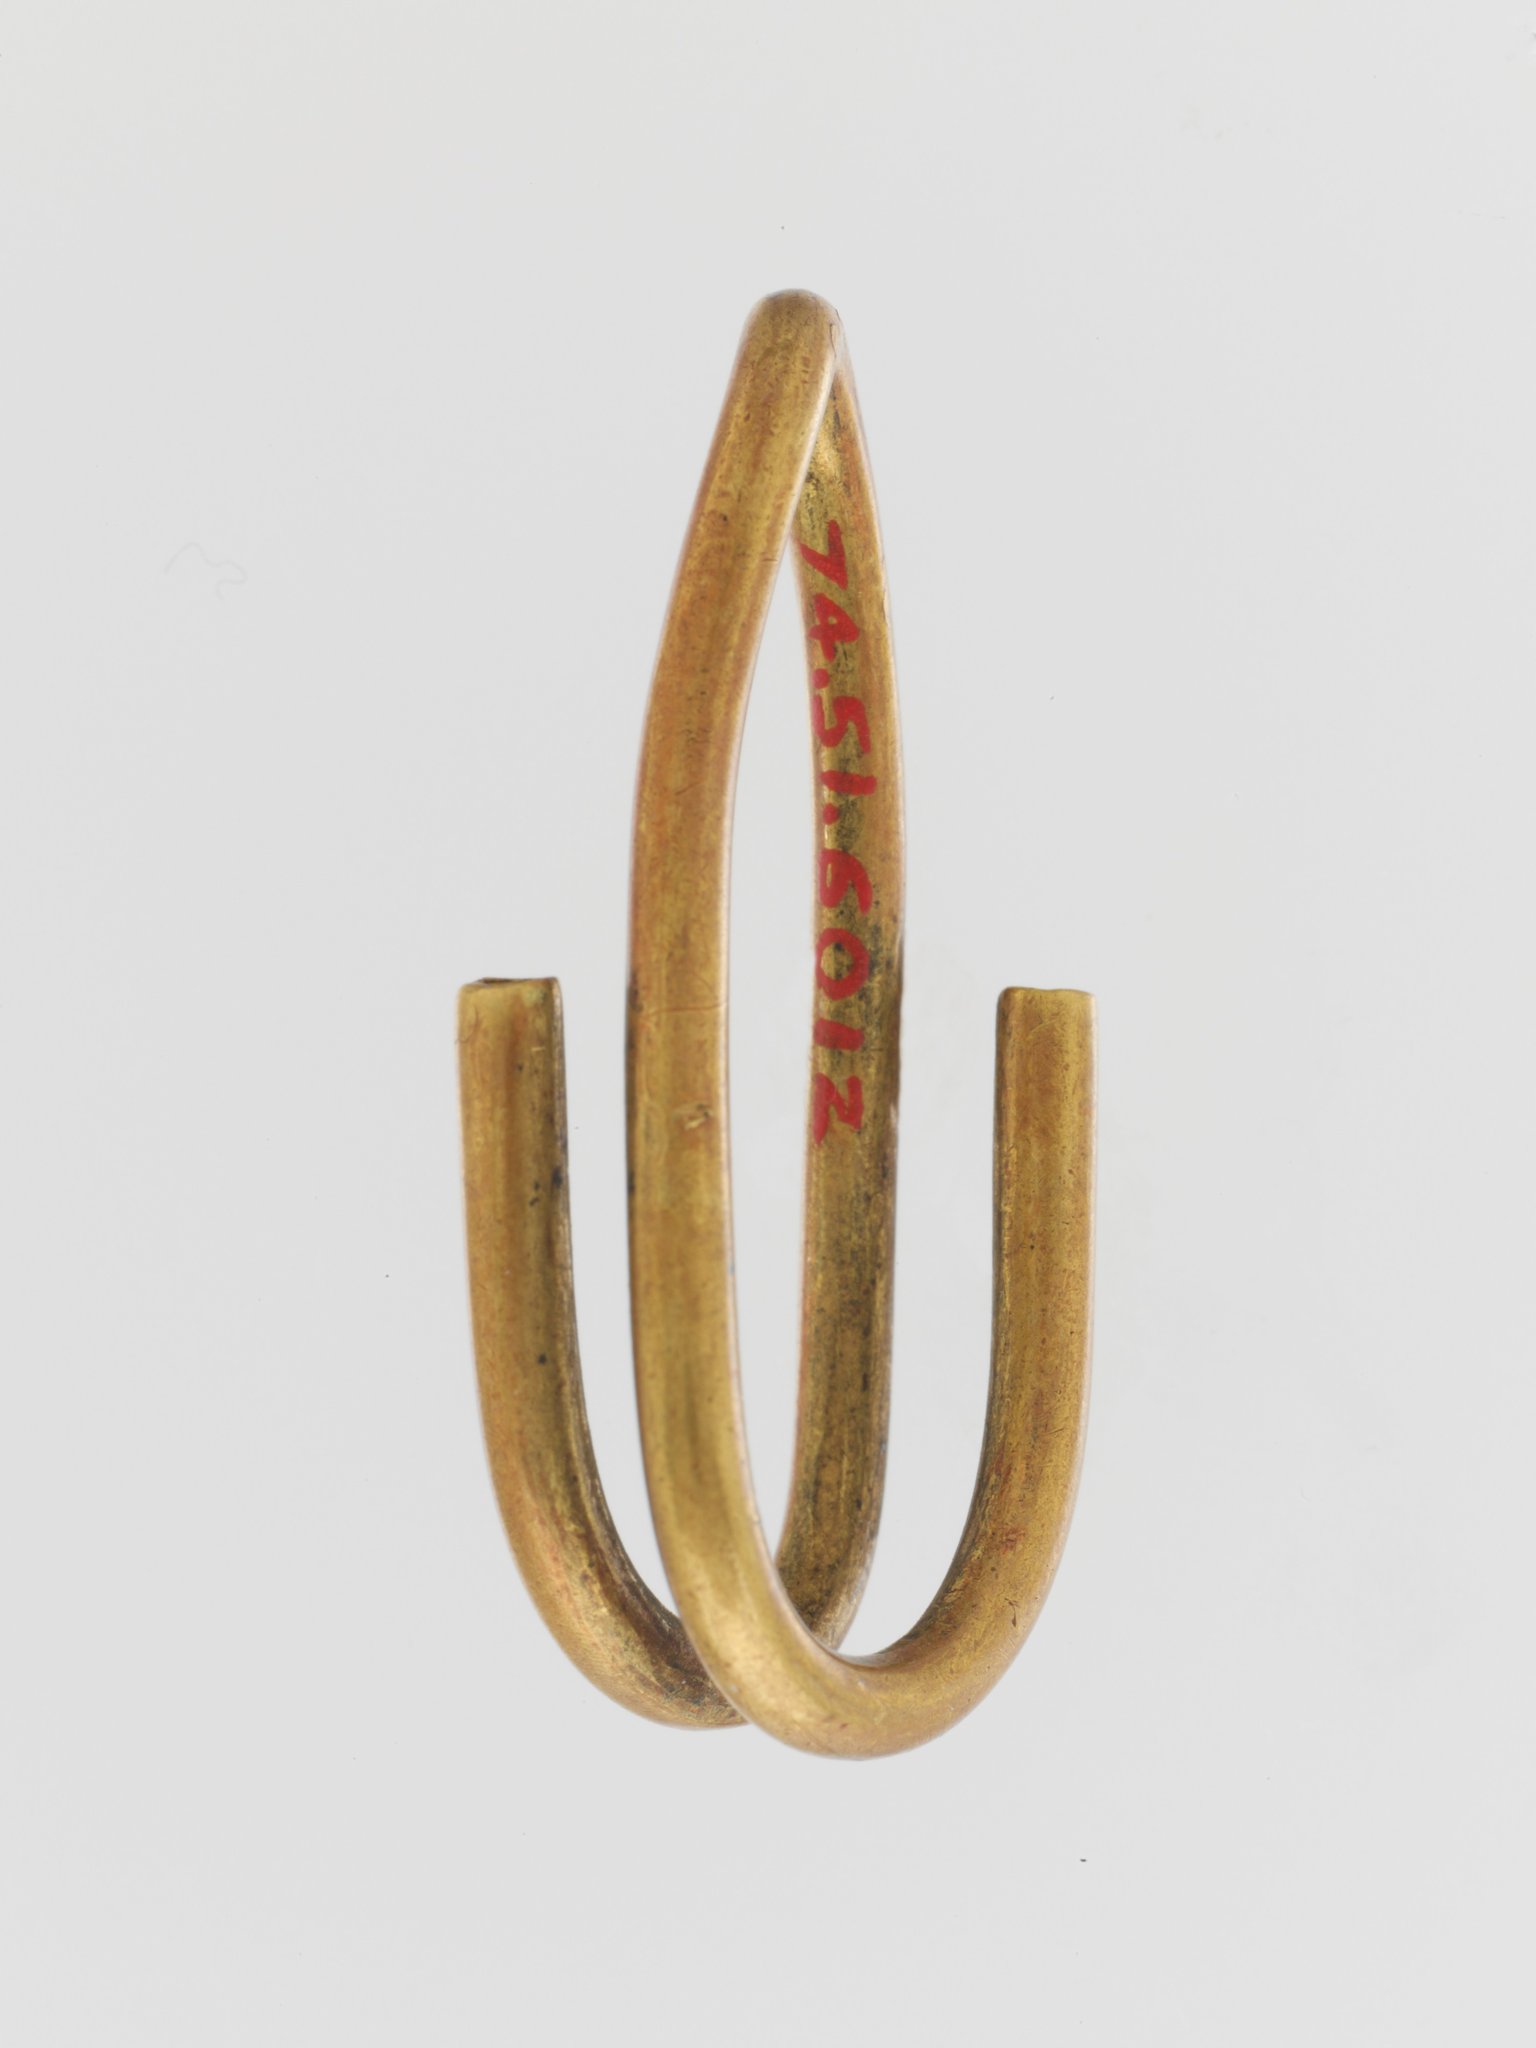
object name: earring or spiral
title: Gold spiral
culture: cypriot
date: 1600-1100 BCE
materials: gold